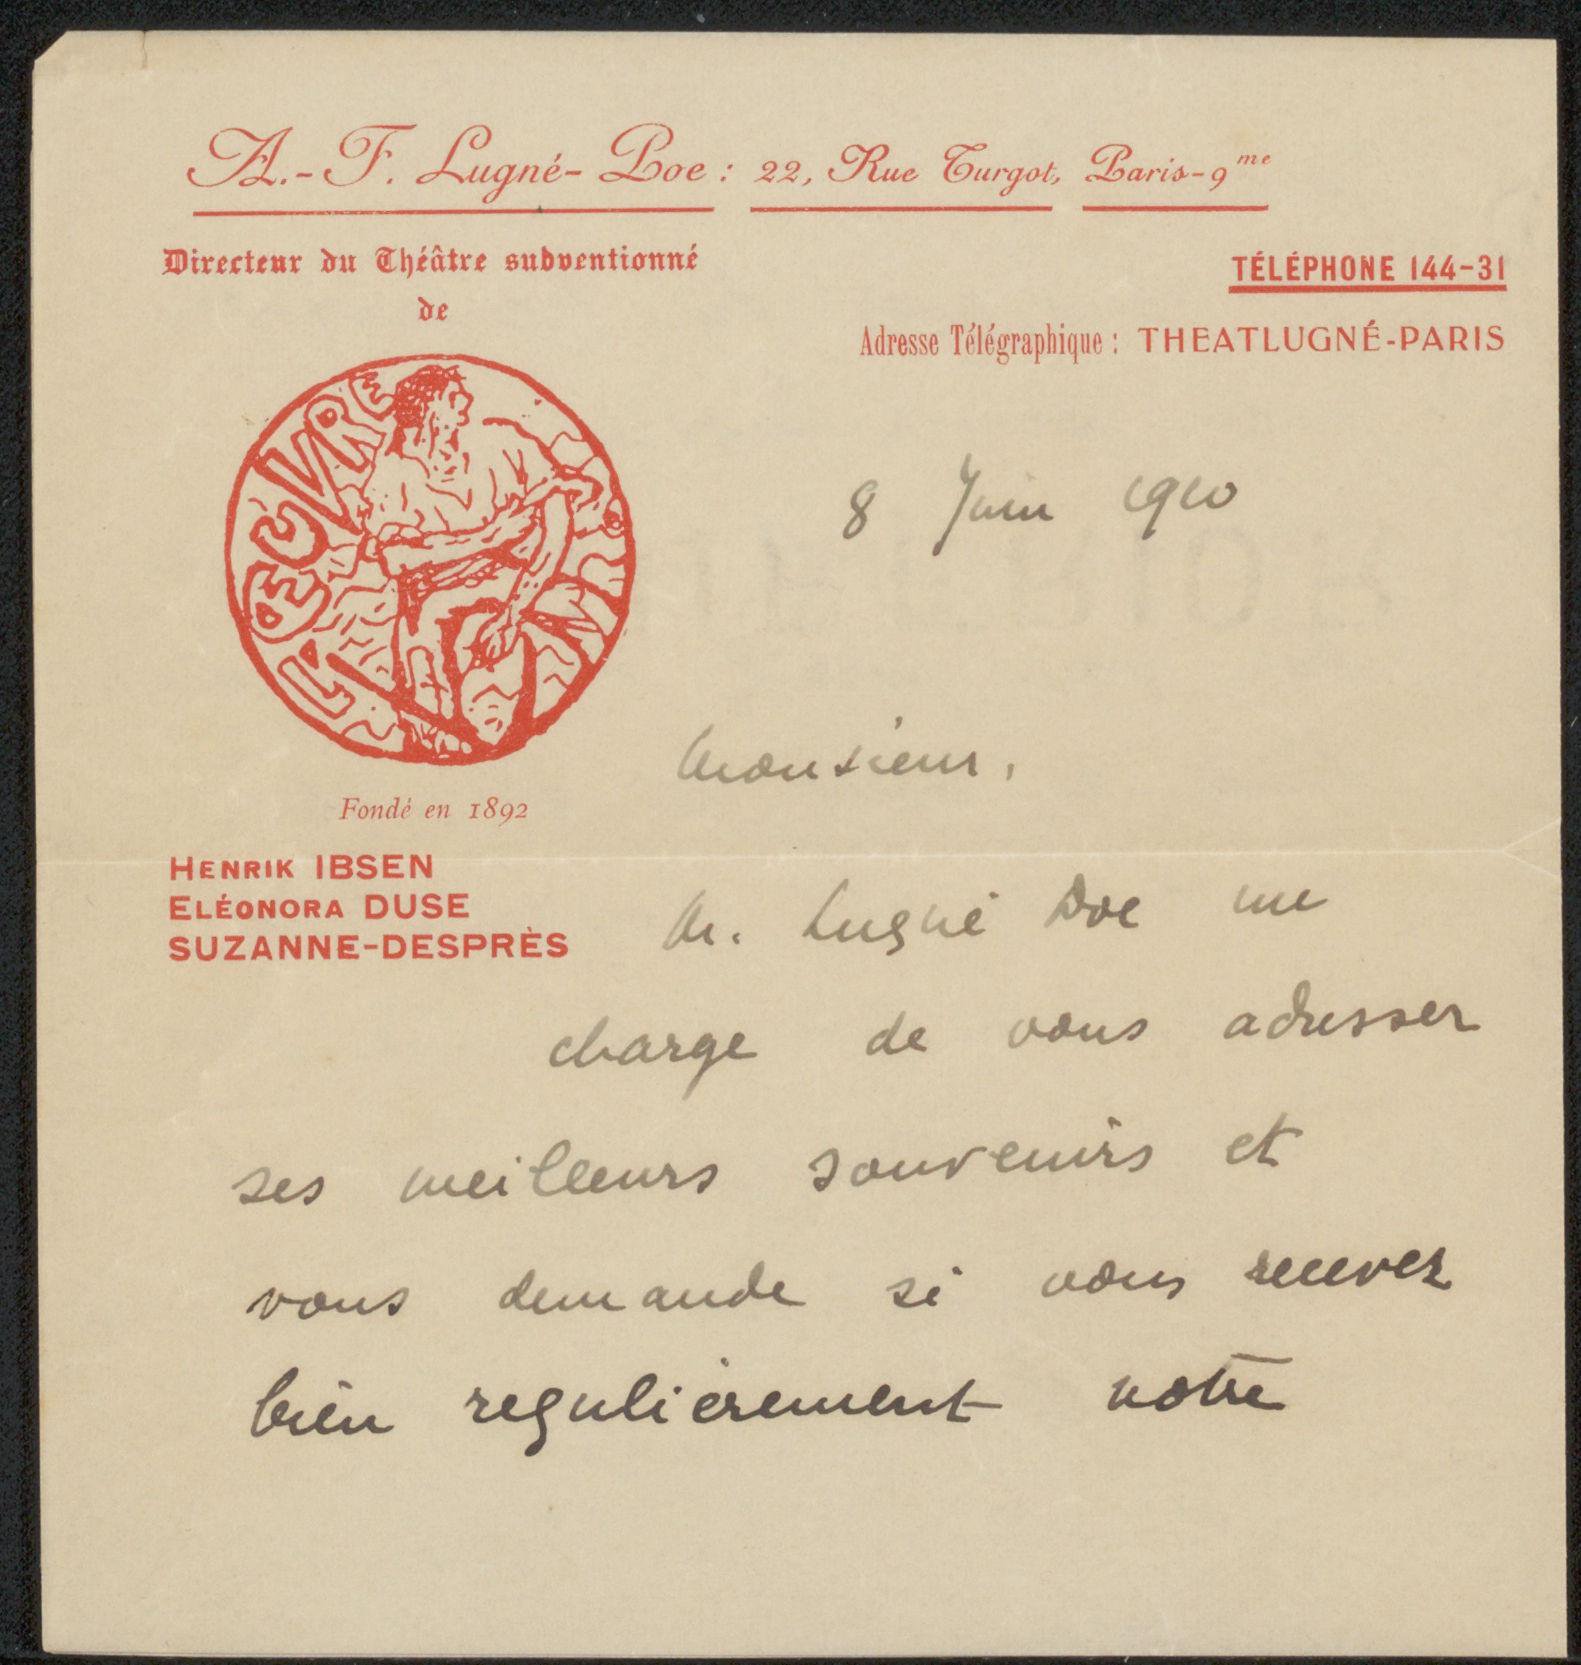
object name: letter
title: Brief aan Philip Zilcken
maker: e. plichon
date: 1910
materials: ink, paper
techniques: pen, printing, writing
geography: paris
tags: paris, lugné-poe, amsterdam, willem cornelis royaards, painter, draughtsman, philip zilcken, printed matter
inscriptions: watermark, collector's mark: ‘RPK’